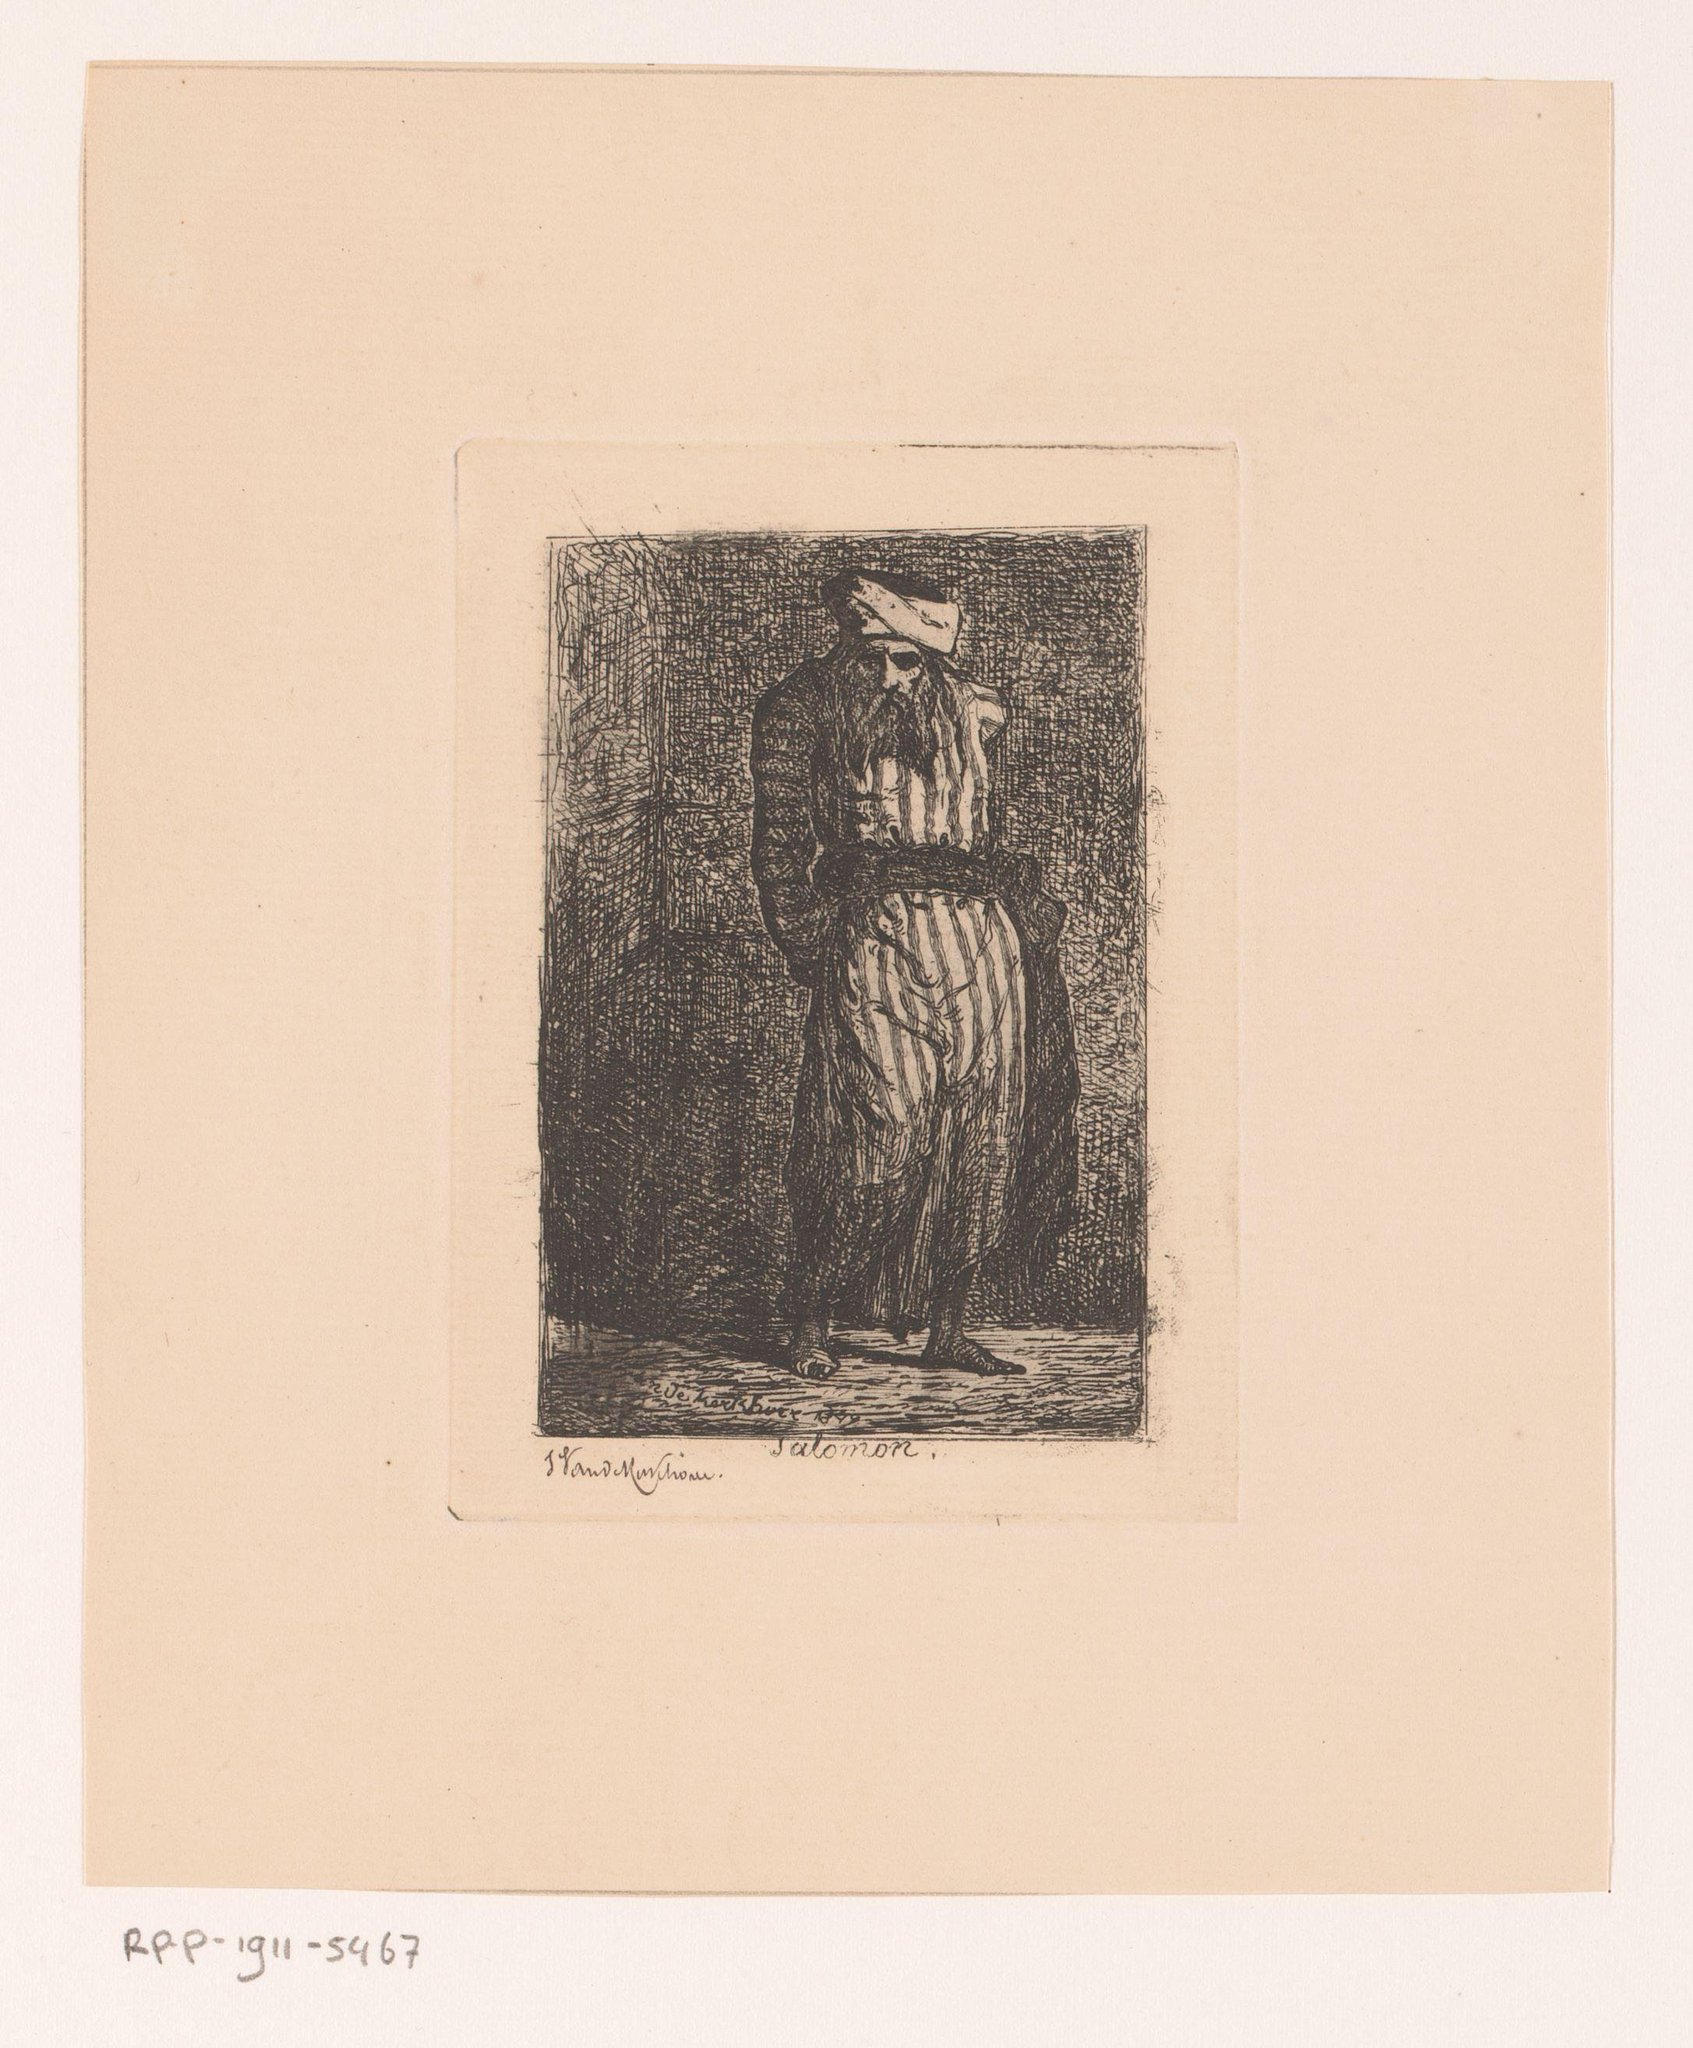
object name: print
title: Salomon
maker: jan van de kerkhove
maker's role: print maker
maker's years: 1822-1881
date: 1849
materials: paper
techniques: etching, intaglio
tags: solomon (not in biblical context); possible attributes of solomon: crown, sceptre, sword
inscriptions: collector's mark: Lugt 2228